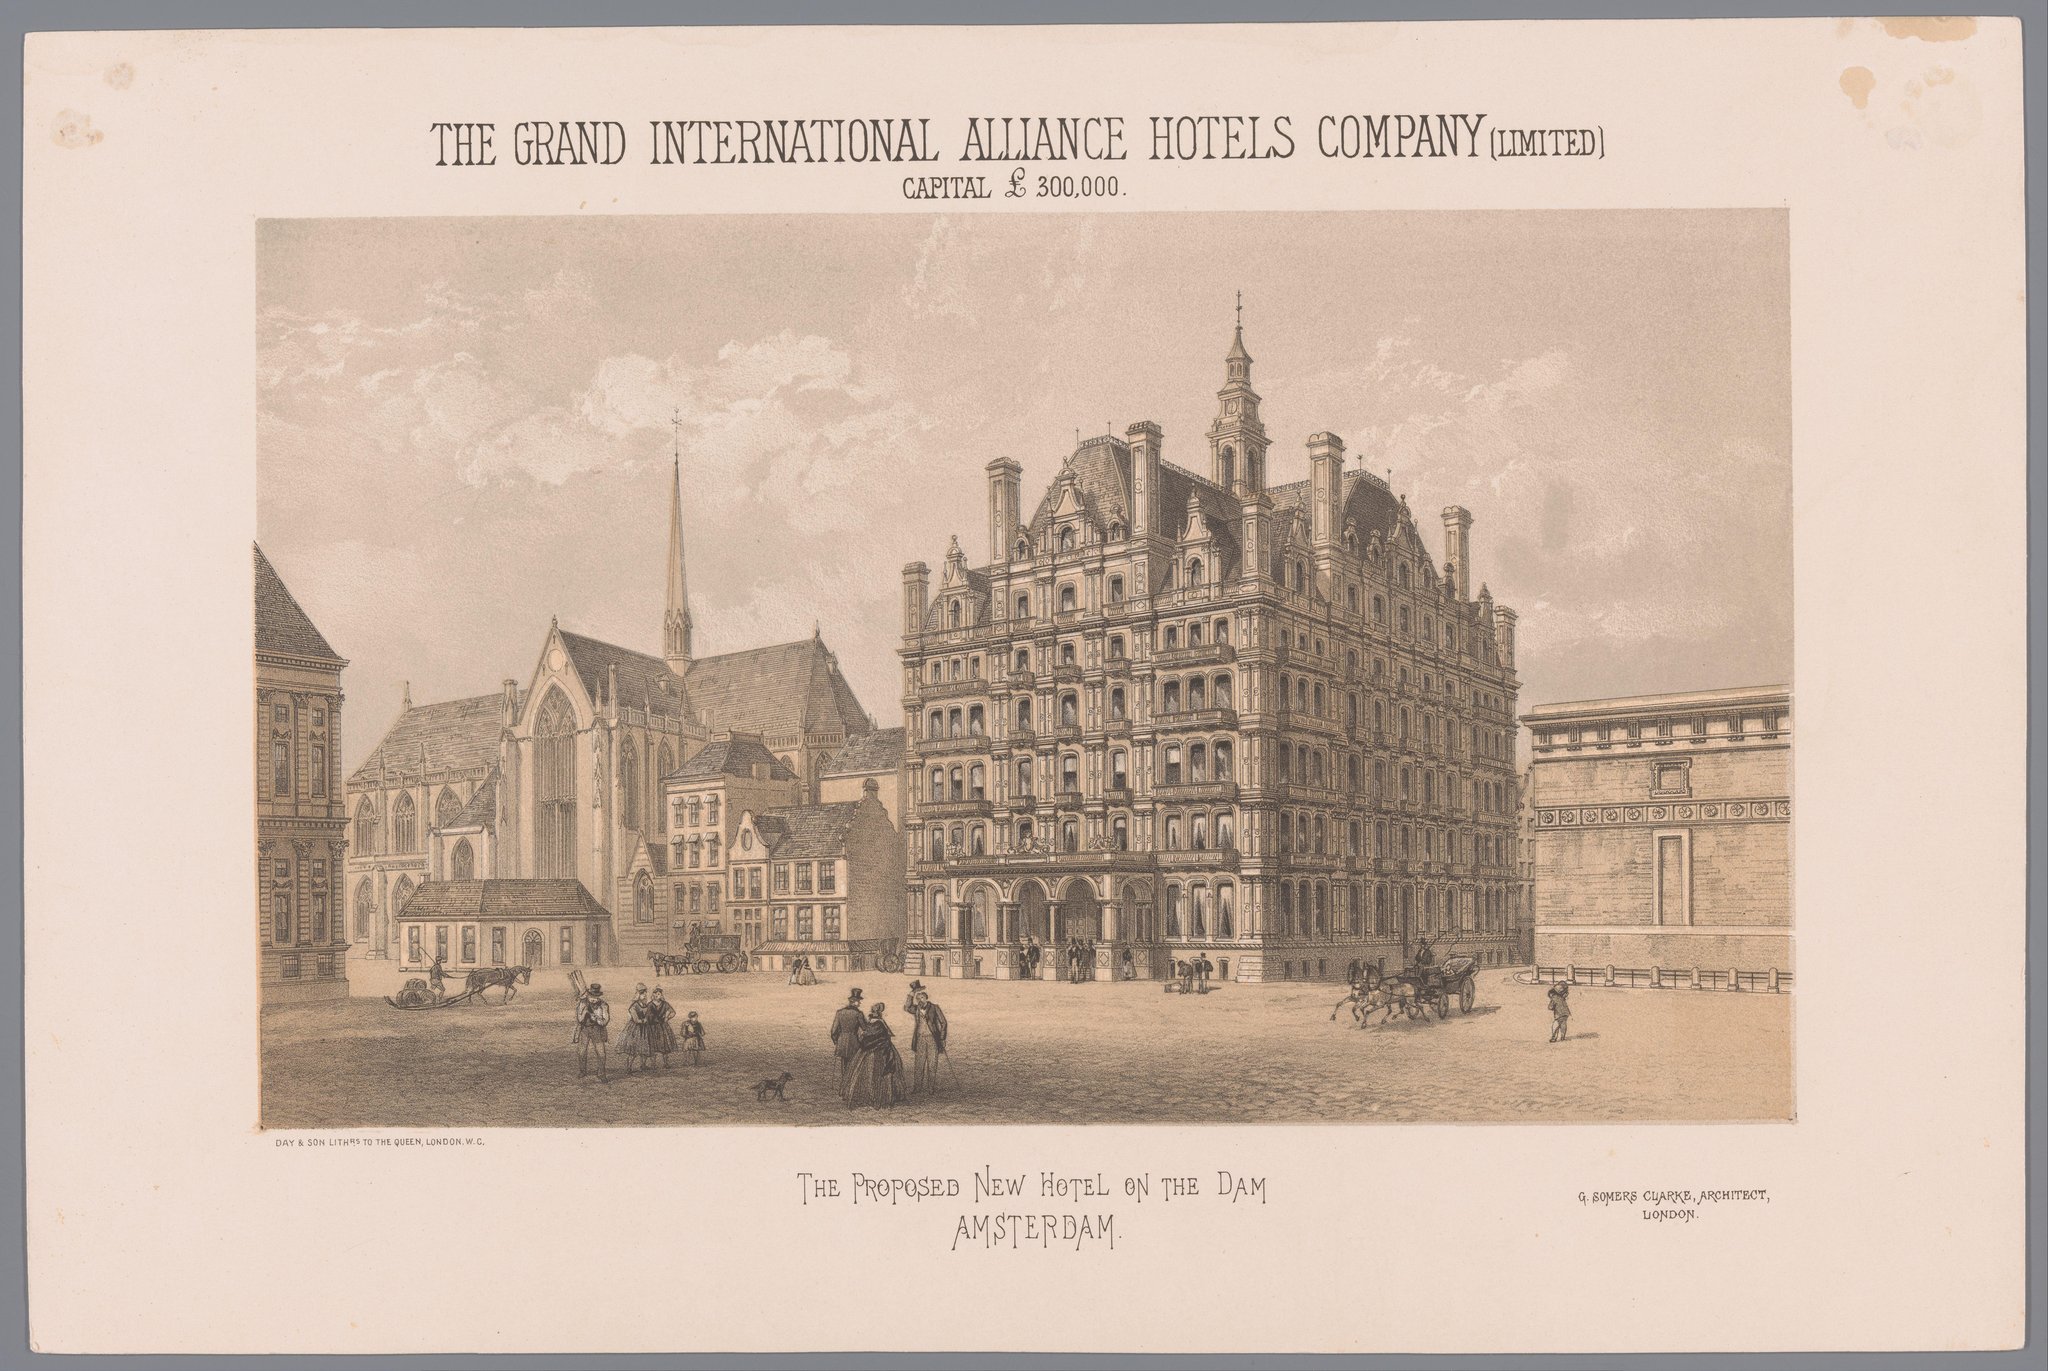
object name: print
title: Ontwerp voor een voorgesteld hotel op de Dam in Amsterdam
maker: Anonymous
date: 1862-1870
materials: paper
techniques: tone lithography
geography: london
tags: hotel, hostelry, inn, edifice, e.g.: public building, department store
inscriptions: collector's mark: Lugt 2228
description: Presentatietekening van een ontwerp voor een niet uitgevoerd hotel aan de noordzijde van de Dam tussen Damrak en Nieuwendijk (op de plaats van de huidige nummers 2-4). Rechts de Beurs van Zocher, links de Nieuwe Kerk en een gedeelte van het Paleis op de Dam.